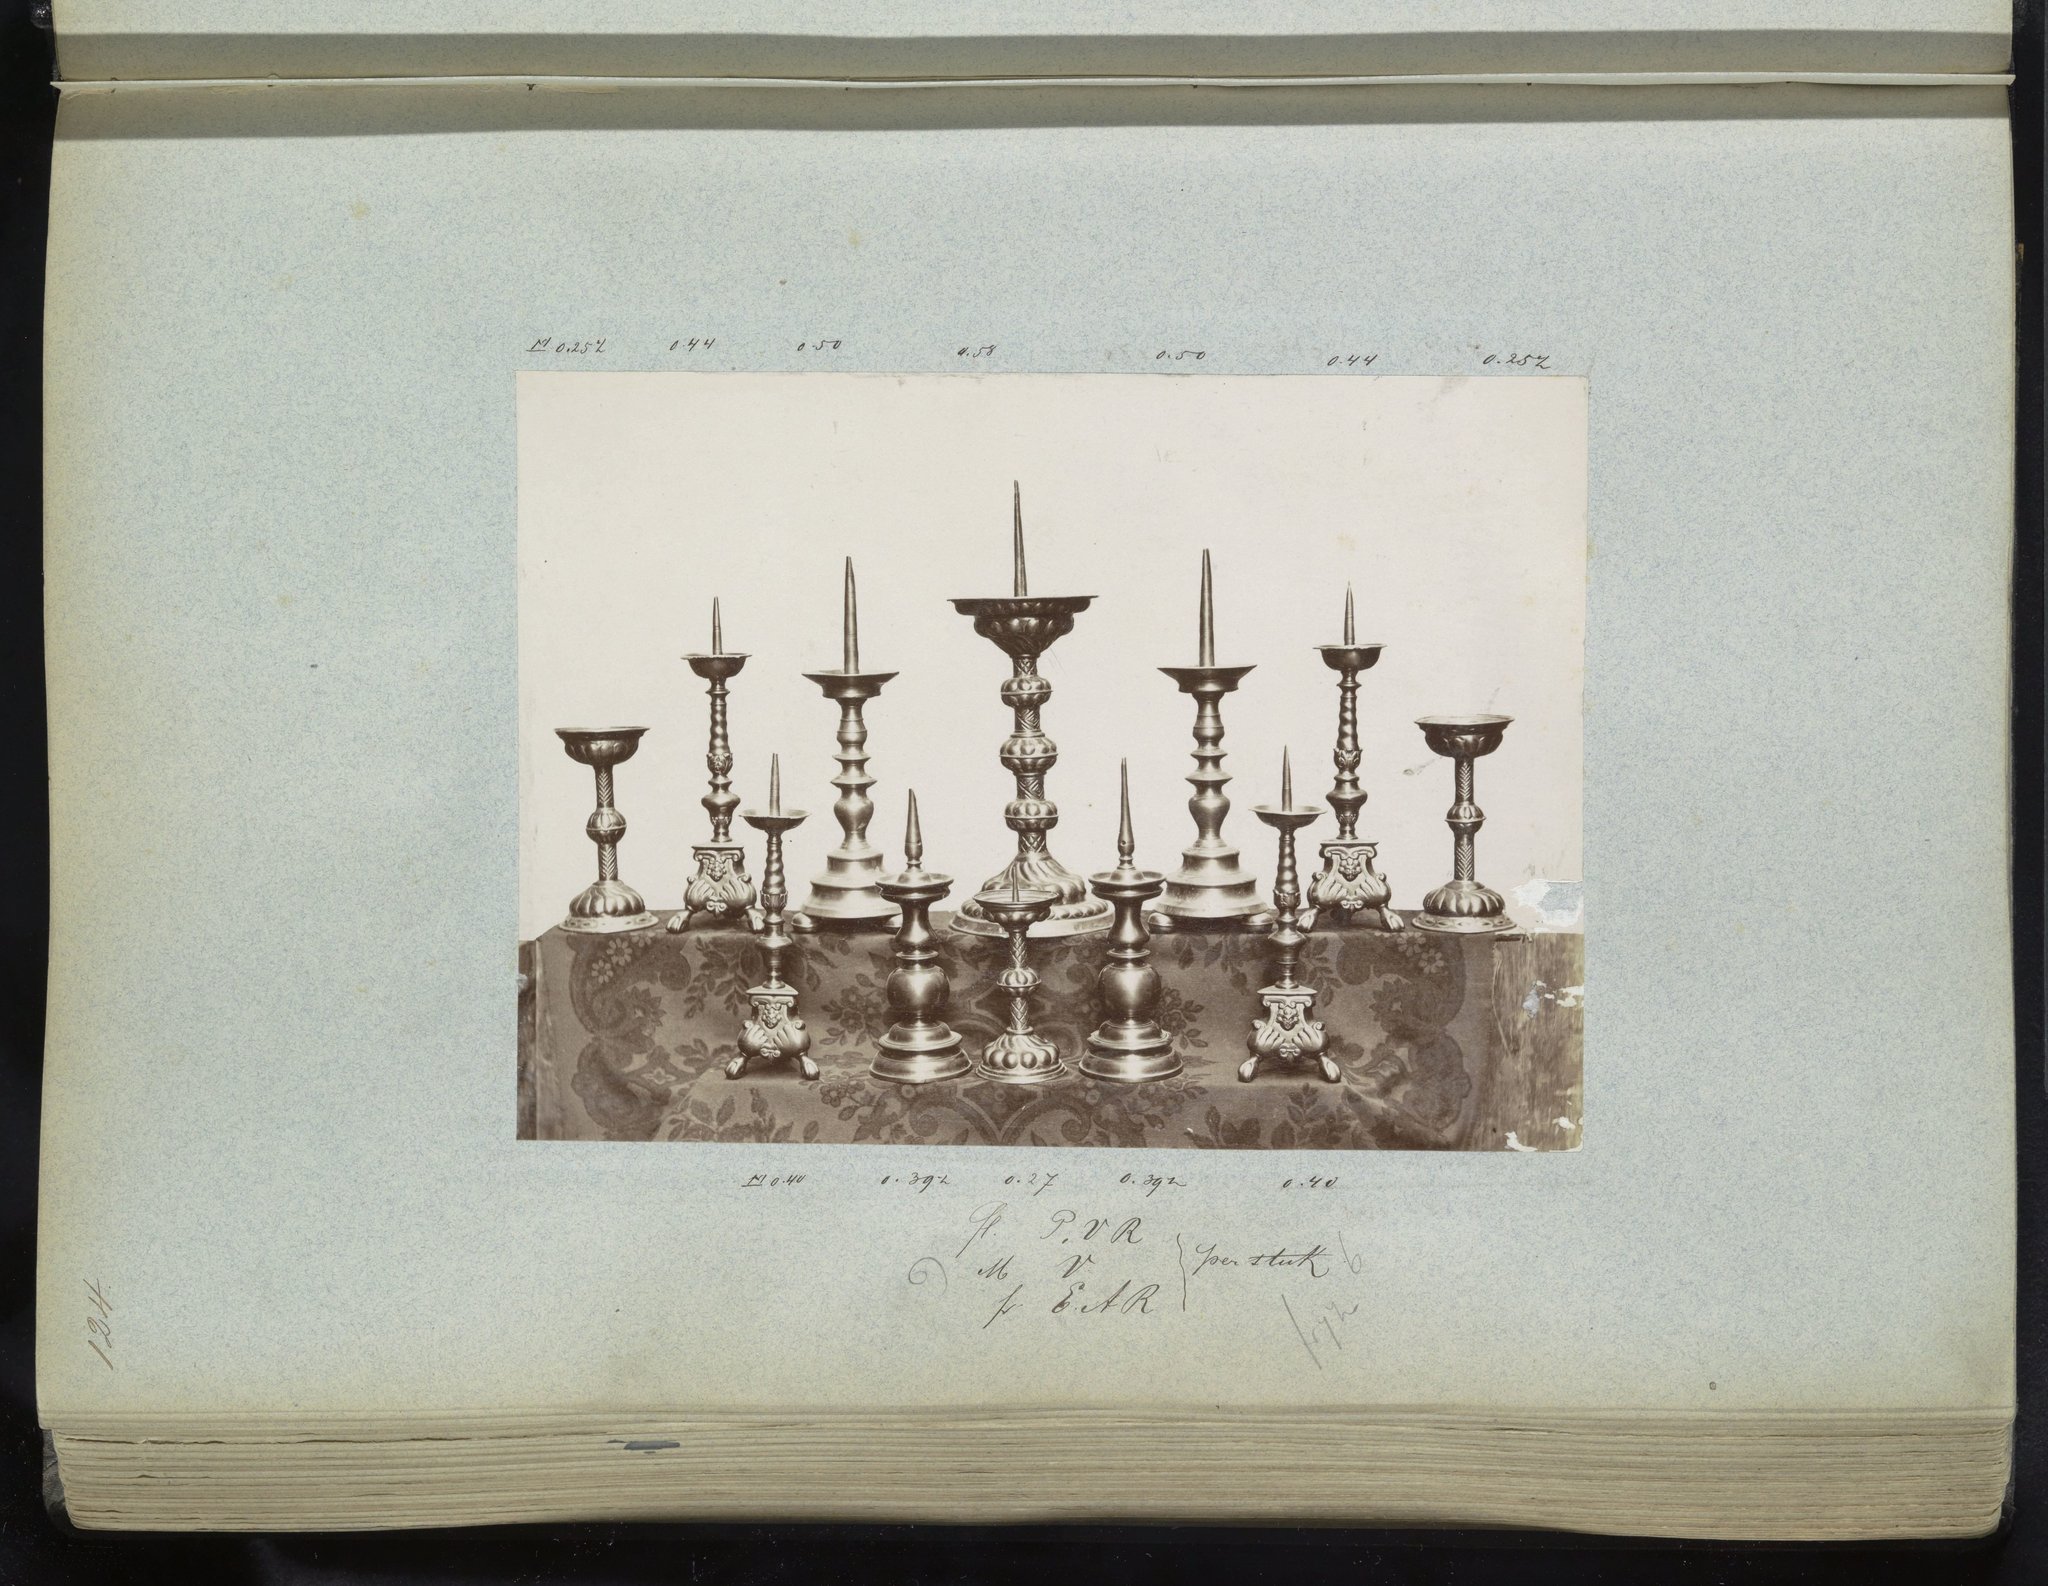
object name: photograph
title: Twaalf koperen kandelaars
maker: Anonymous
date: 1875-1900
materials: paper, photographic support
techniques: albumen print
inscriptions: annotation, annotation